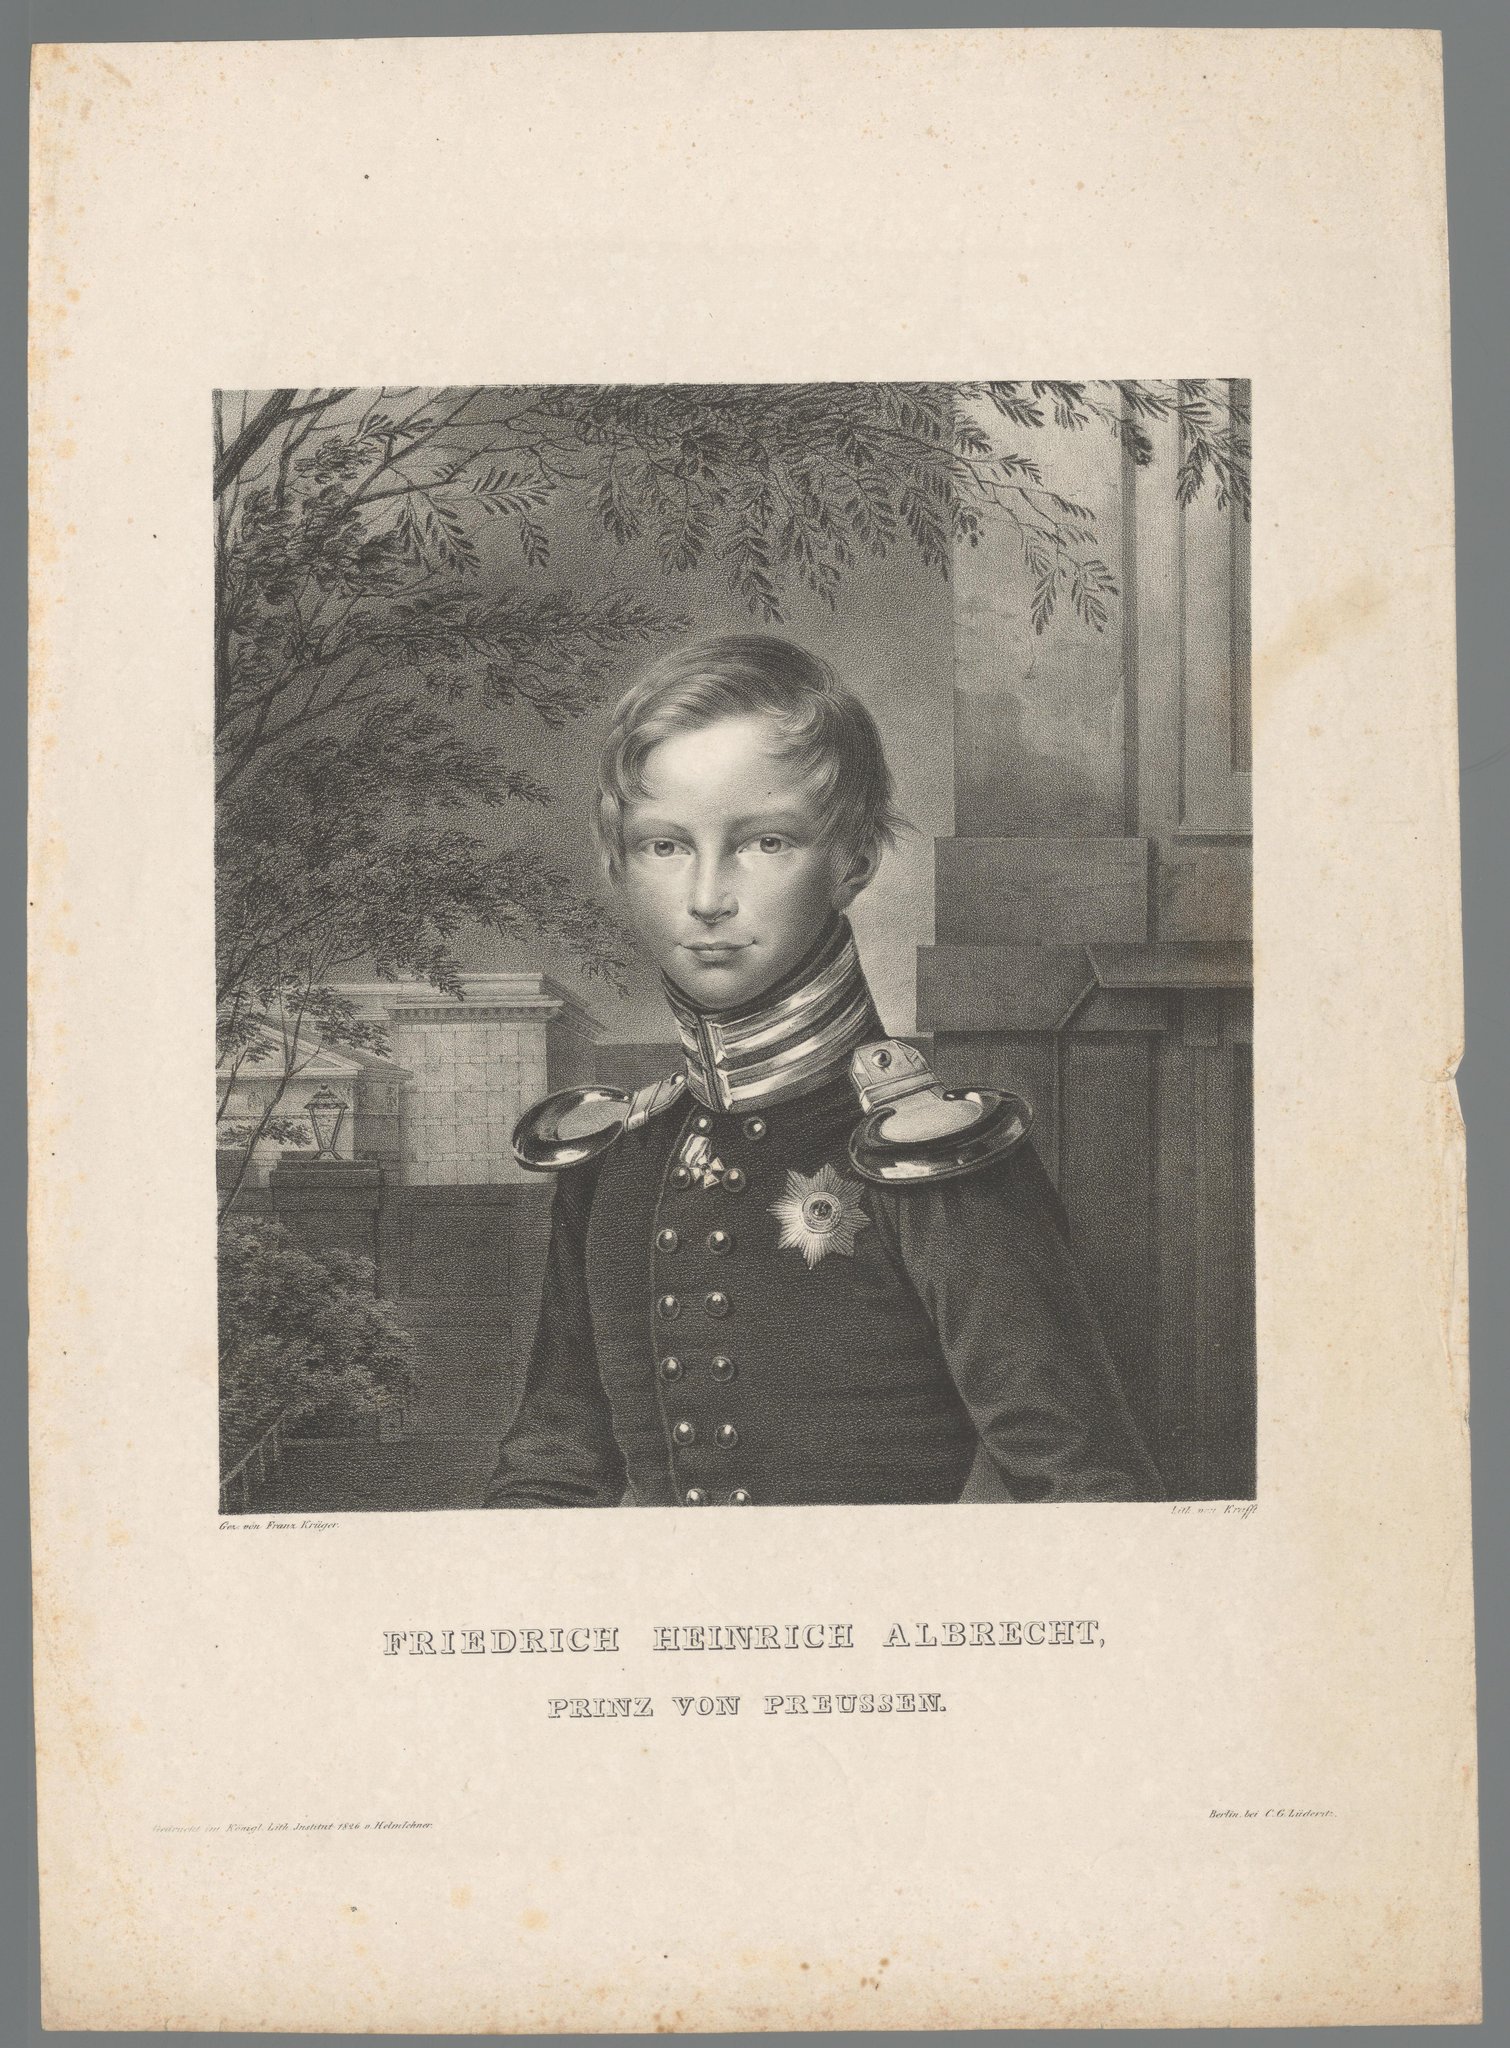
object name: print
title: Friedrich Heinrich Albrecht Prinz von Preussen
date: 1807-1840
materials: paper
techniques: lithograph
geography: berlin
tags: prince, historical persons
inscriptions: collector's mark: Lugt 2228